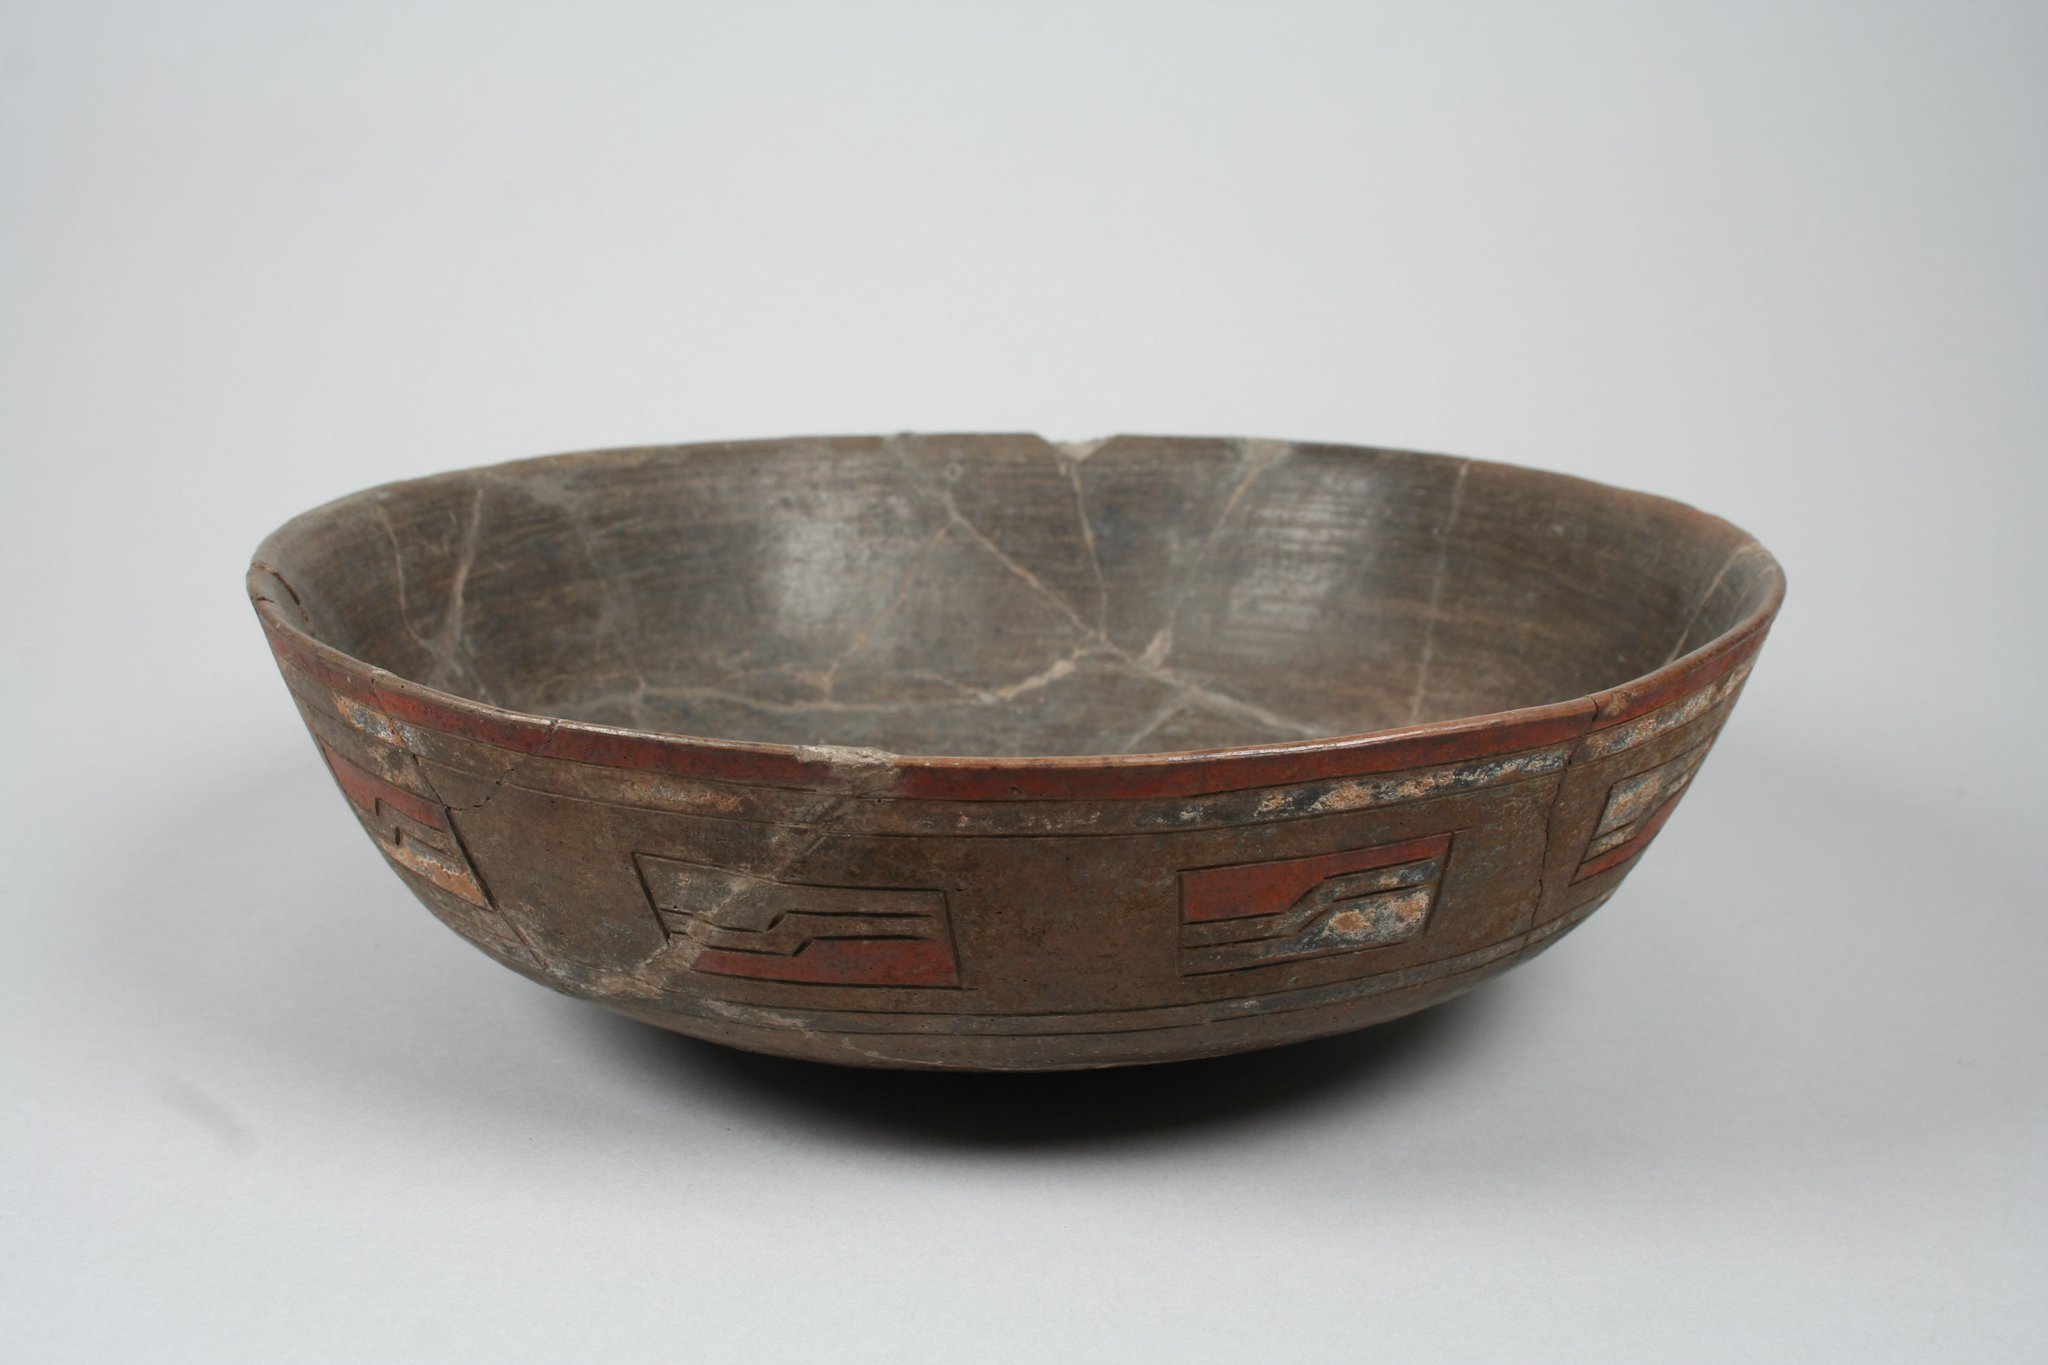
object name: bowl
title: Incised bowl with geometric pattern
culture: paracas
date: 300-101 BCE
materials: ceramic, pigment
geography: peru